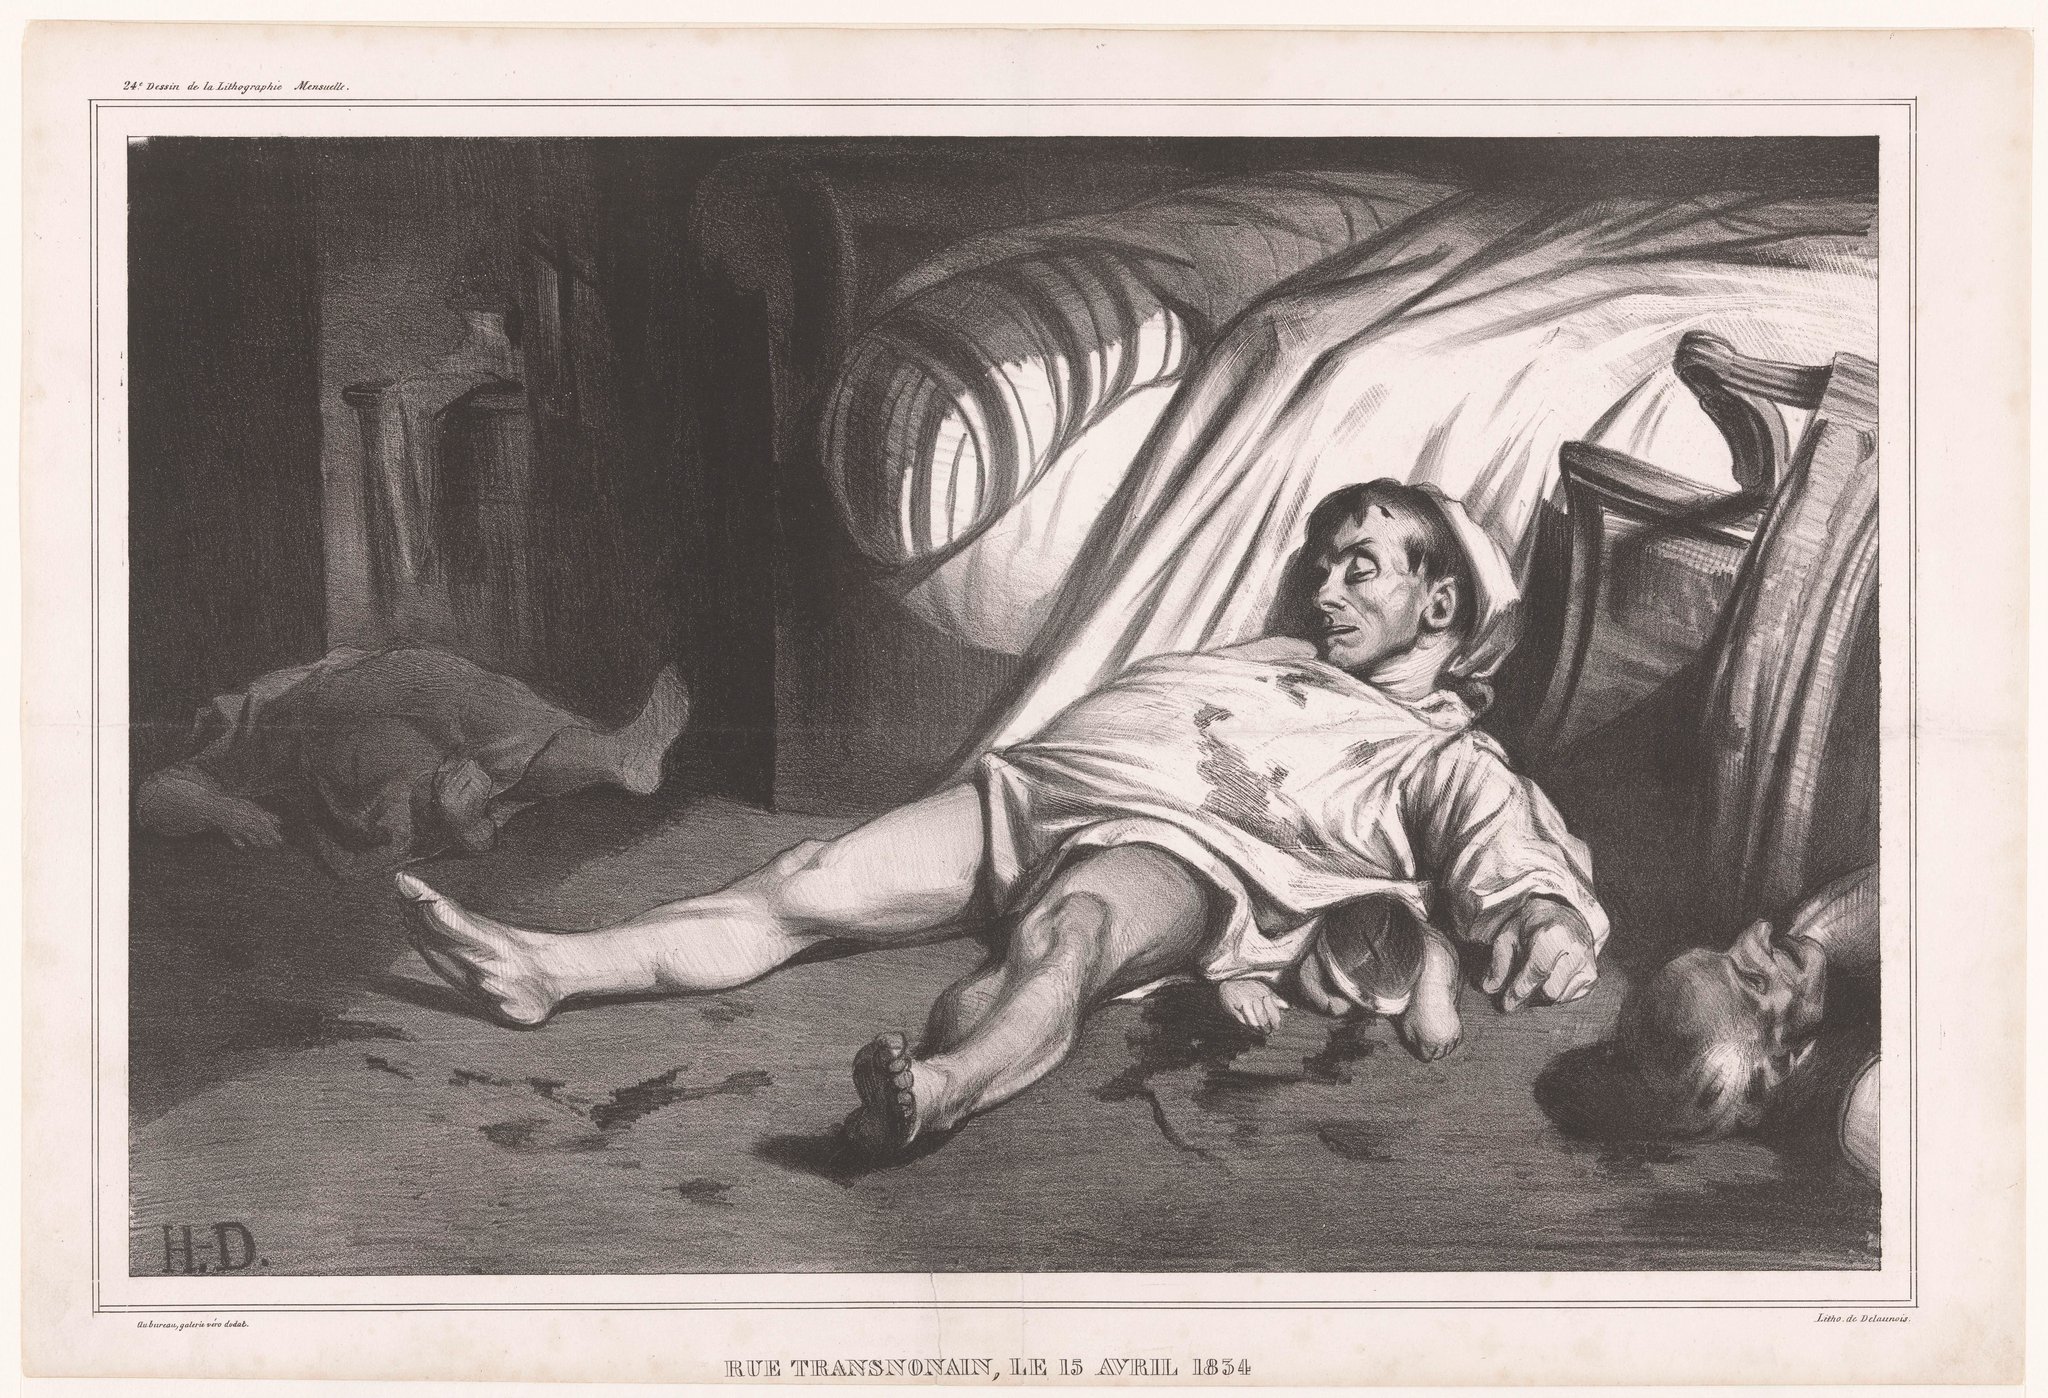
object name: print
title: Rue Transnonain, le 15 avril 1834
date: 1834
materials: paper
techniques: lithograph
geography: paris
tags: murder, the corpse, revolution, revolt, massacre ~ war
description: Prent gepubliceerd in: L'Association mensuelle, juni 1834, pl. 24.